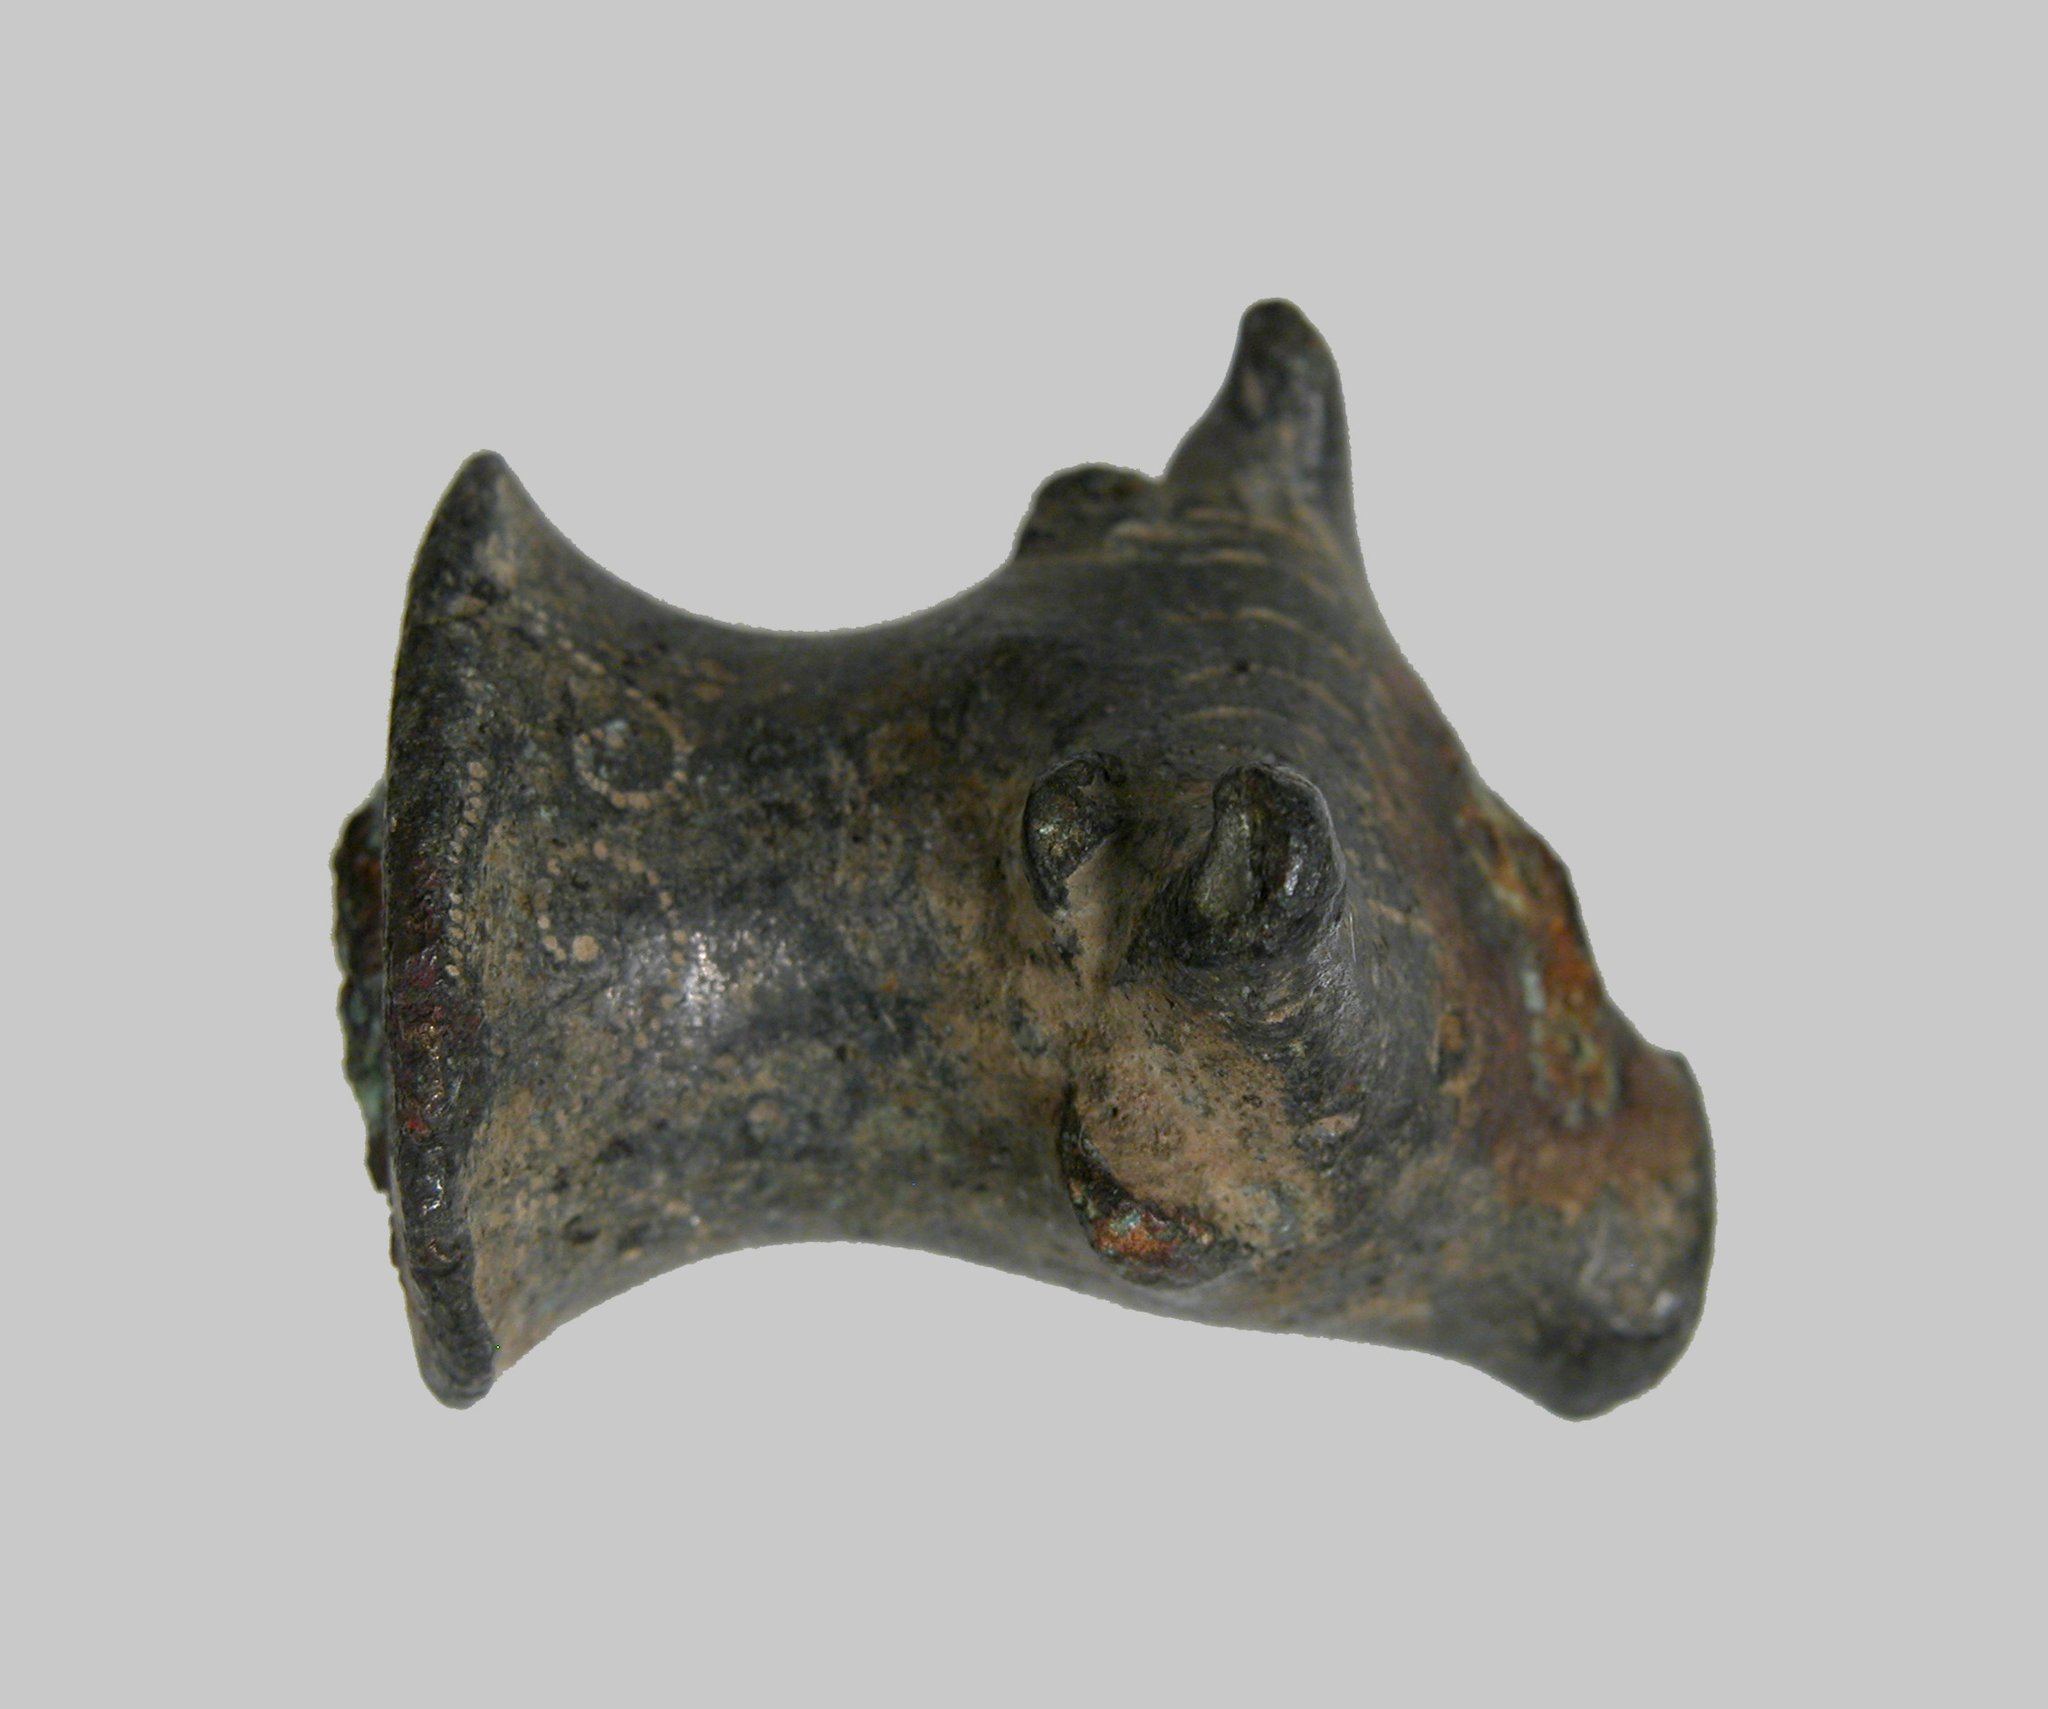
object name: key handle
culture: roman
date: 1-700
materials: copper alloy